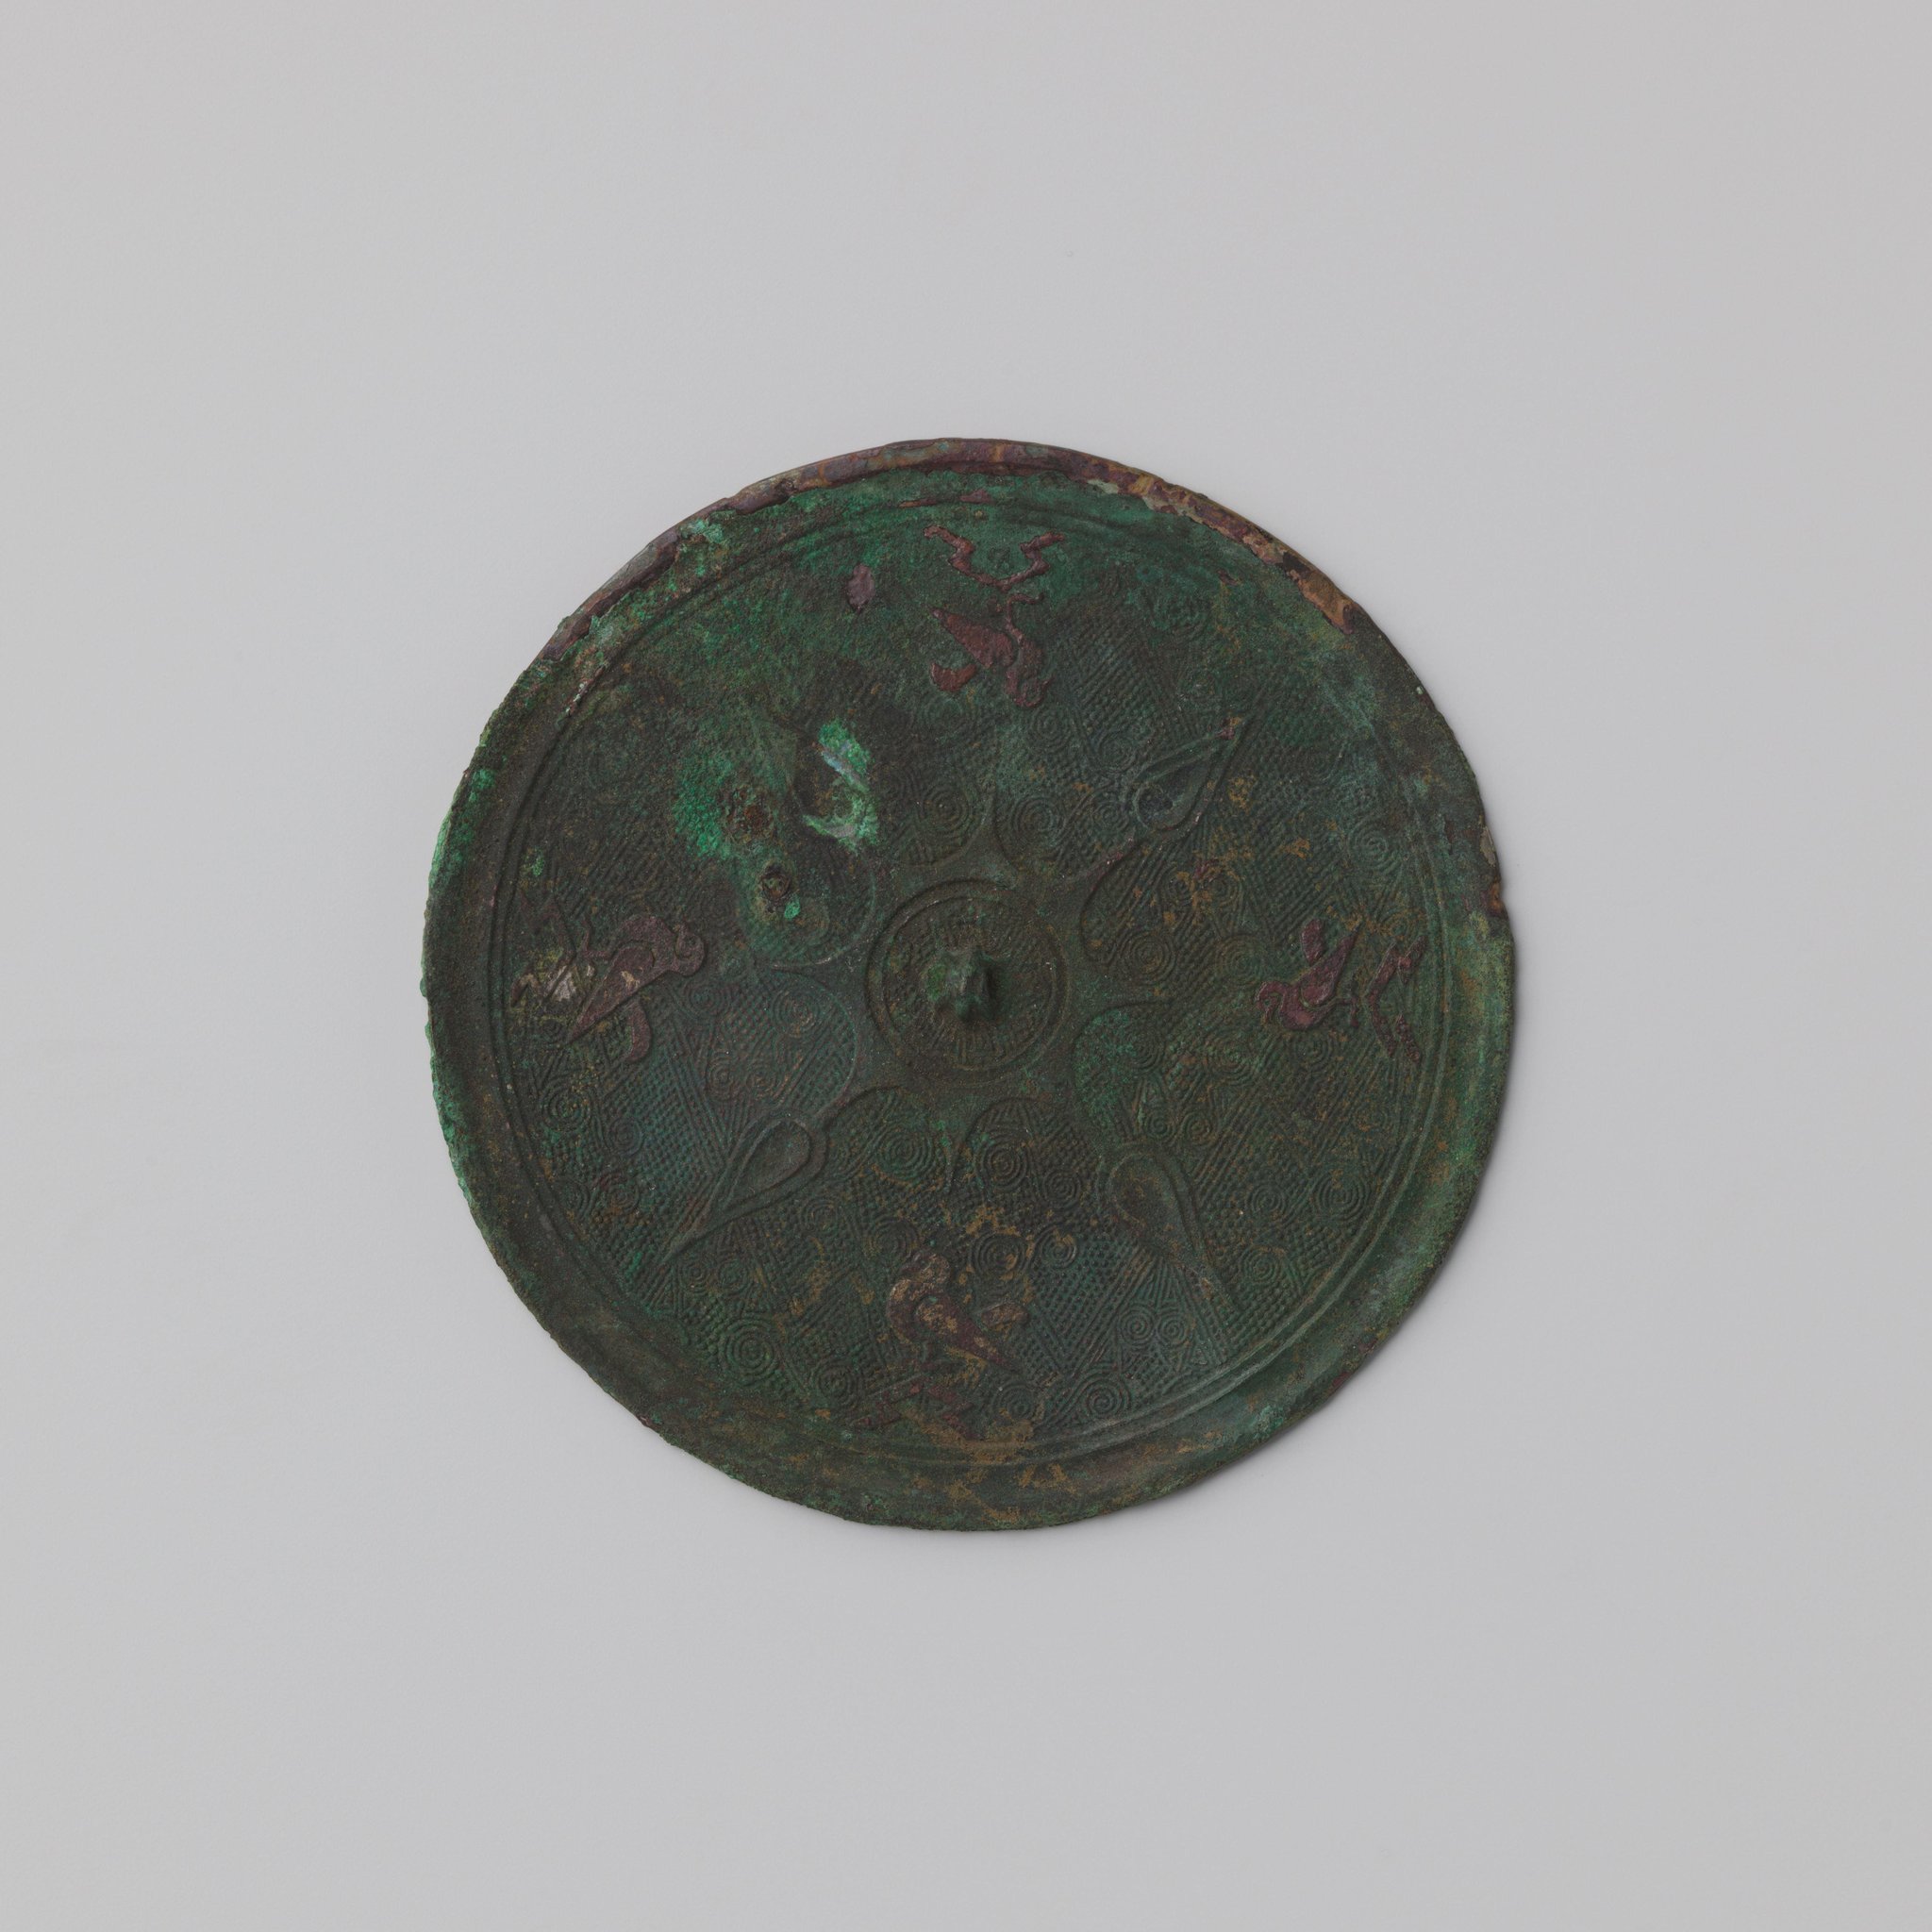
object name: mirror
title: Spiegel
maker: Anonymous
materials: bronze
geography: china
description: Mirror with star motif and four birds. Late Eastern Zhou period (481 - 222 BC).